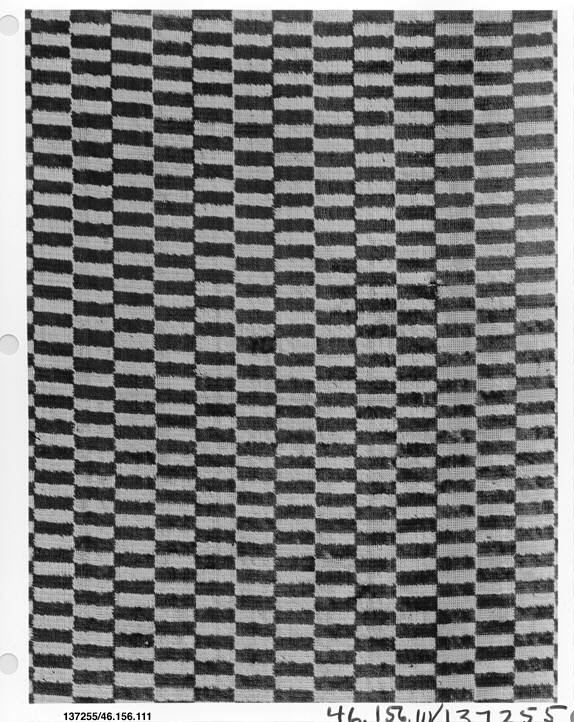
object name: piece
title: Length of double-sided cut velvet and plush silk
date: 1567-1633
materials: silk, velvet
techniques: cutting